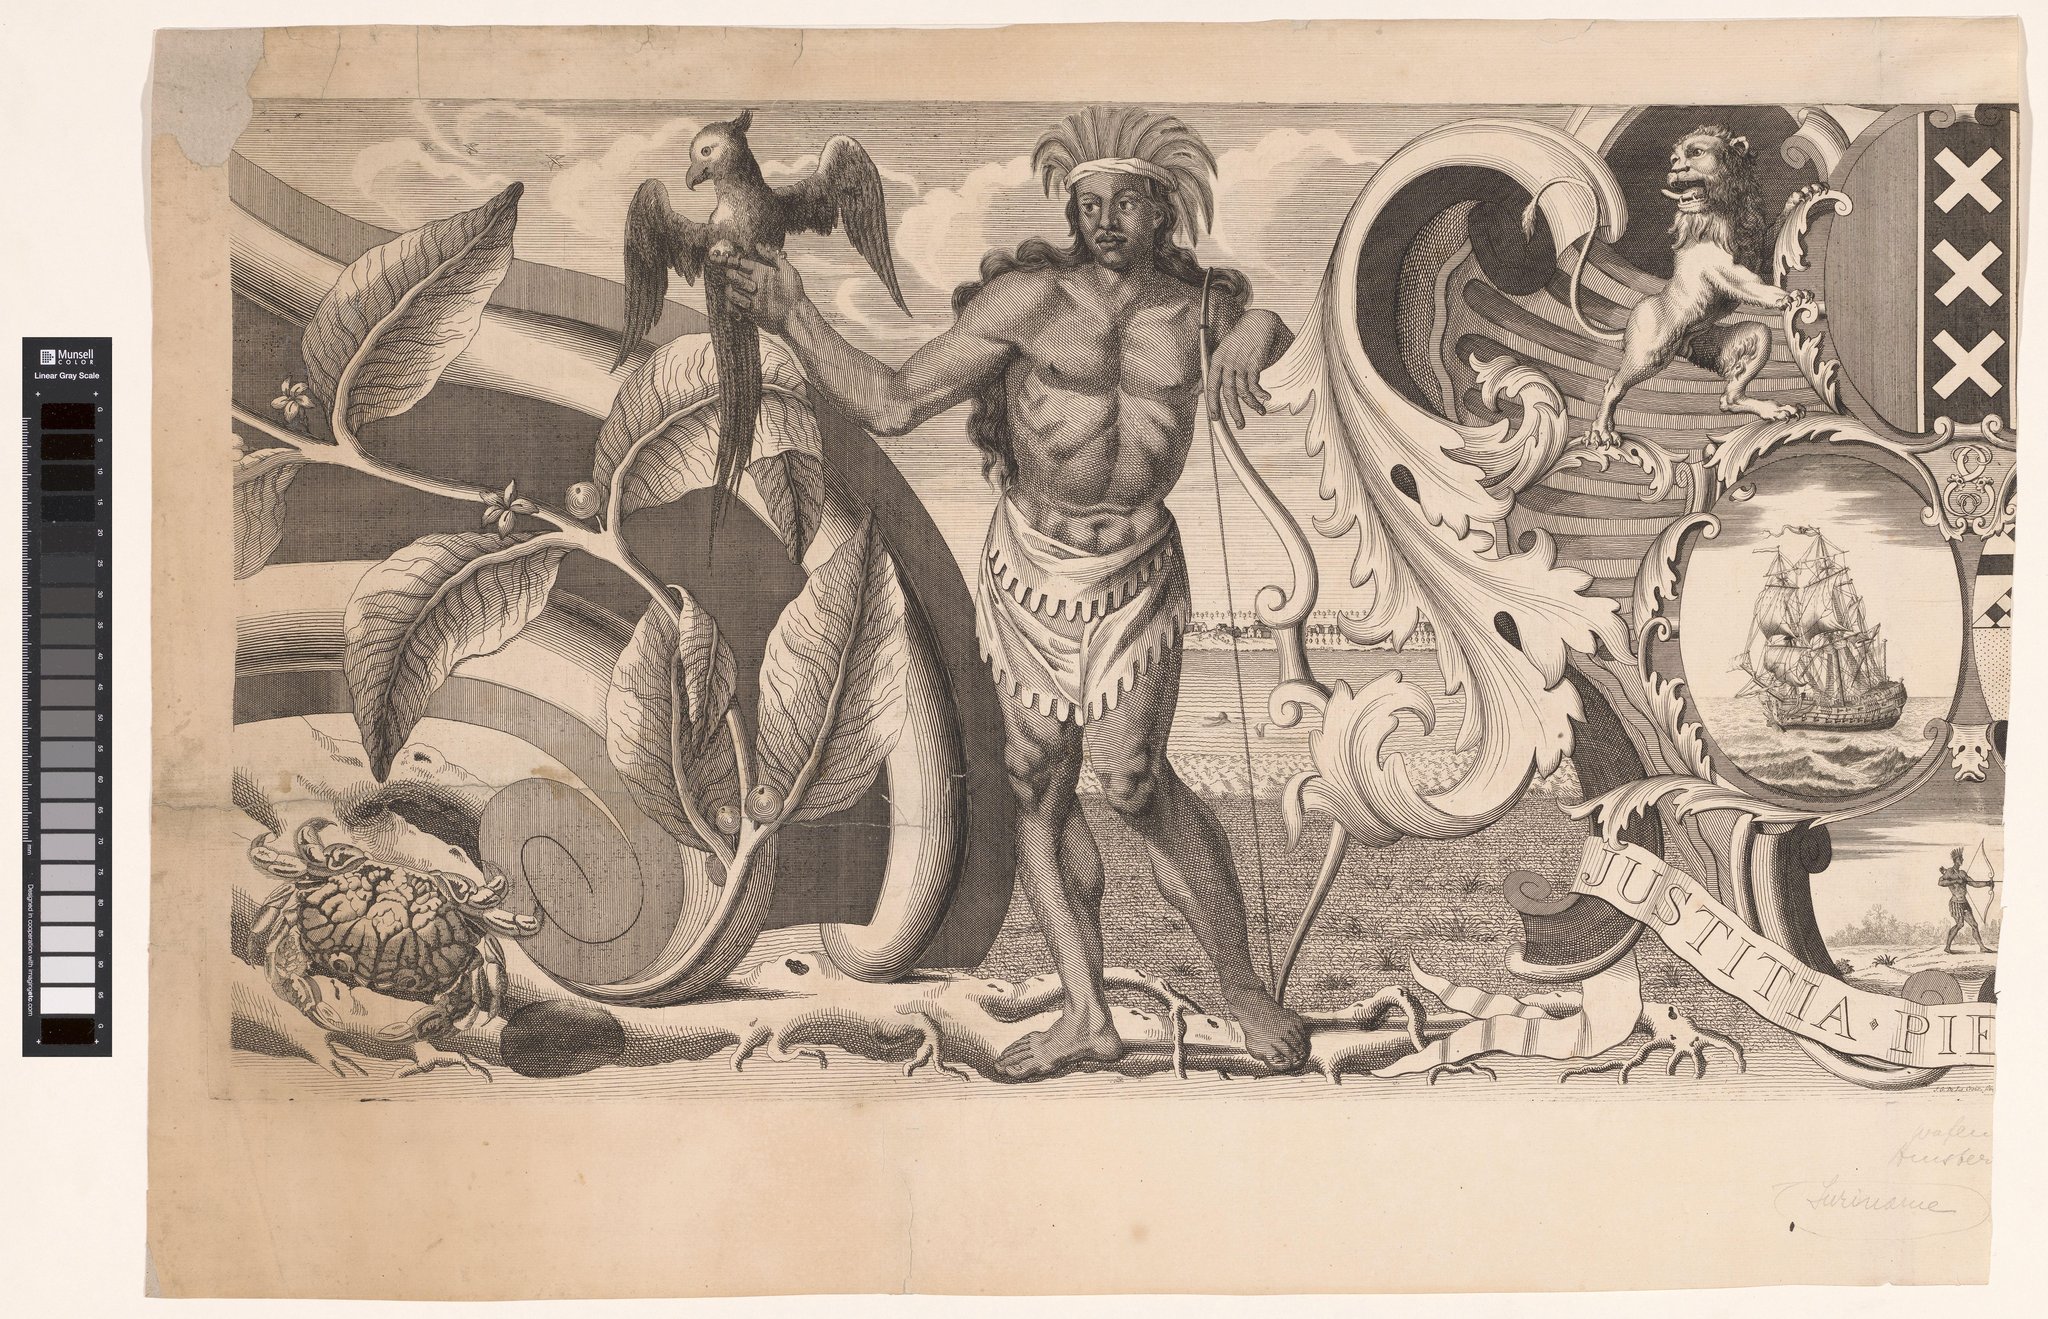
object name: print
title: Deel van de rand van een kaart van Suriname (linkerdeel)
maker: j.g. de la croix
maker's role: painter, print maker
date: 1737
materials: paper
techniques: engraving, etching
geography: netherlands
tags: coat of arms (as symbol of the state, etc.), sailing-ship, sailing-boat, indigenous peoples of south america, slavery; serfs and enslaved persons, crustaceans: crab, ornament derived from plant forms, armorial bearing, heraldry, suriname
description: Twee Surinaamse mannen flankeren een wapen samengesteld uit de wapens van Amsterdam, de WIC en de familie Sommelsdijck. Fragment van een rijkversierde rand rondom een kaart van Suriname.